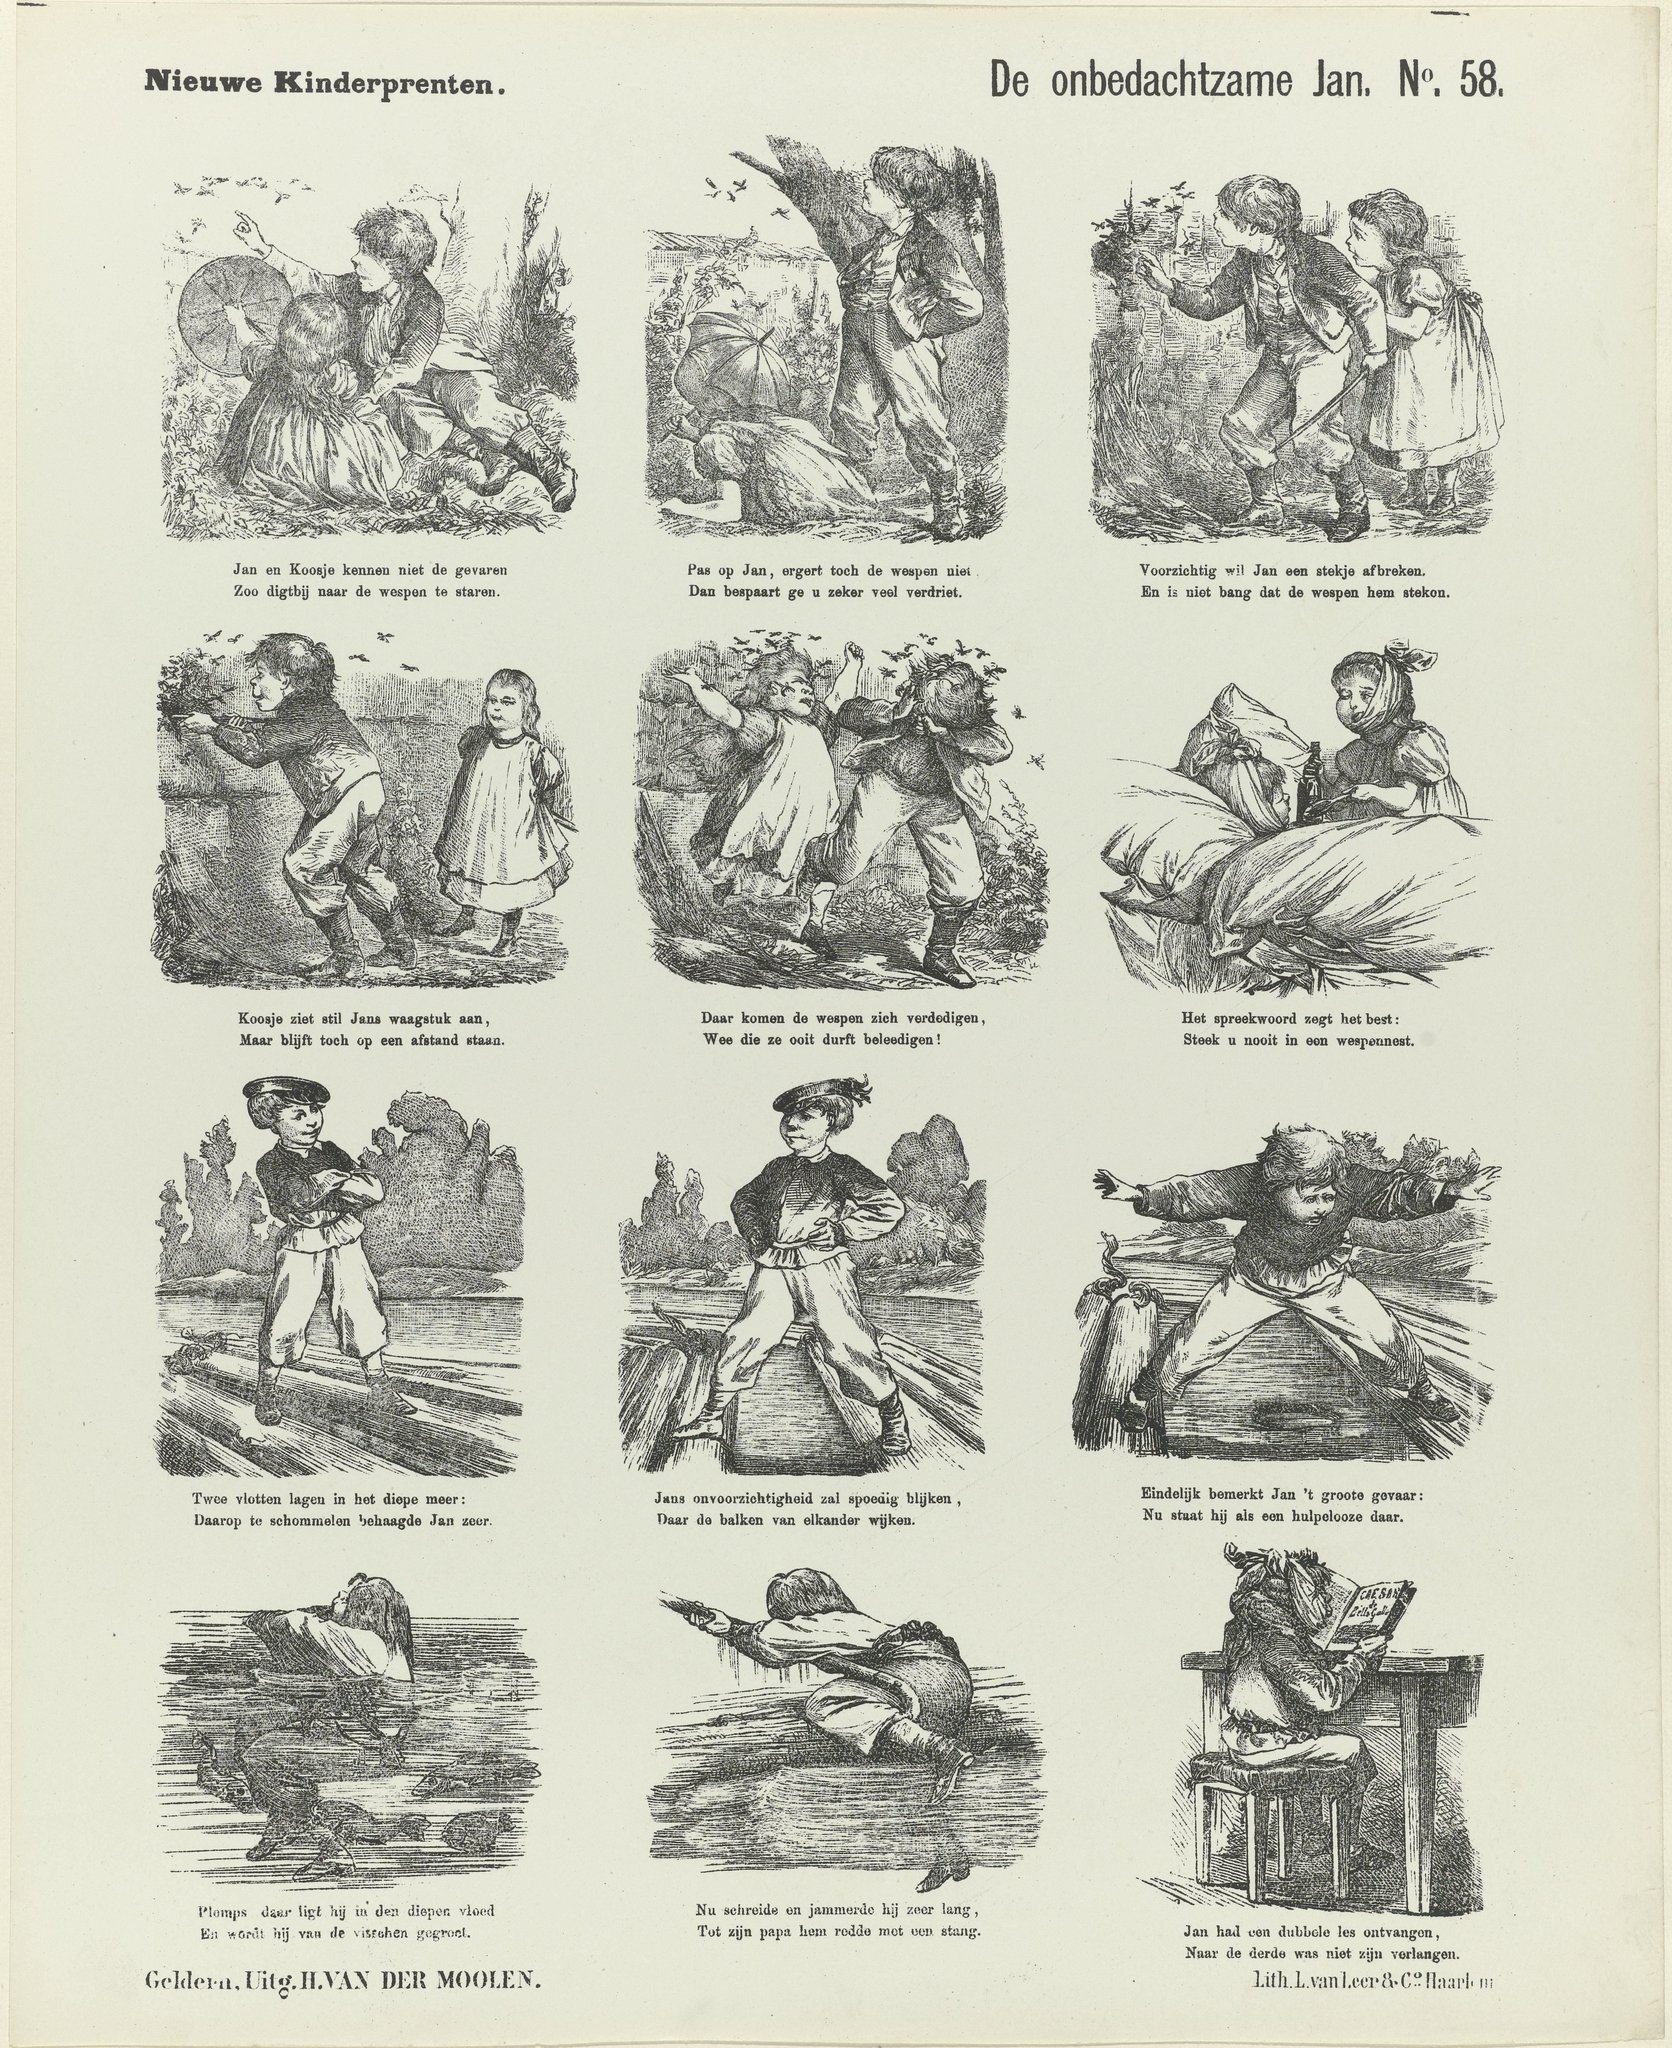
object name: popular print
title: Nieuwe kinderprenten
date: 1838-1892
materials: paper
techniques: letterpress printing, lithograph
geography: geldern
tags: child, bee-hive, raft, pain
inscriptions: collector's mark: Lugt 2760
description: Blad met 12 voorstellingen van kinderen die spelen met een wespennest en ziek in bed eindigen en Jan die speelt op een houten vlot en in het water valt. Onder elke afbeelding een tweeregelig vers. Genummerd rechtsboven: No. 58.